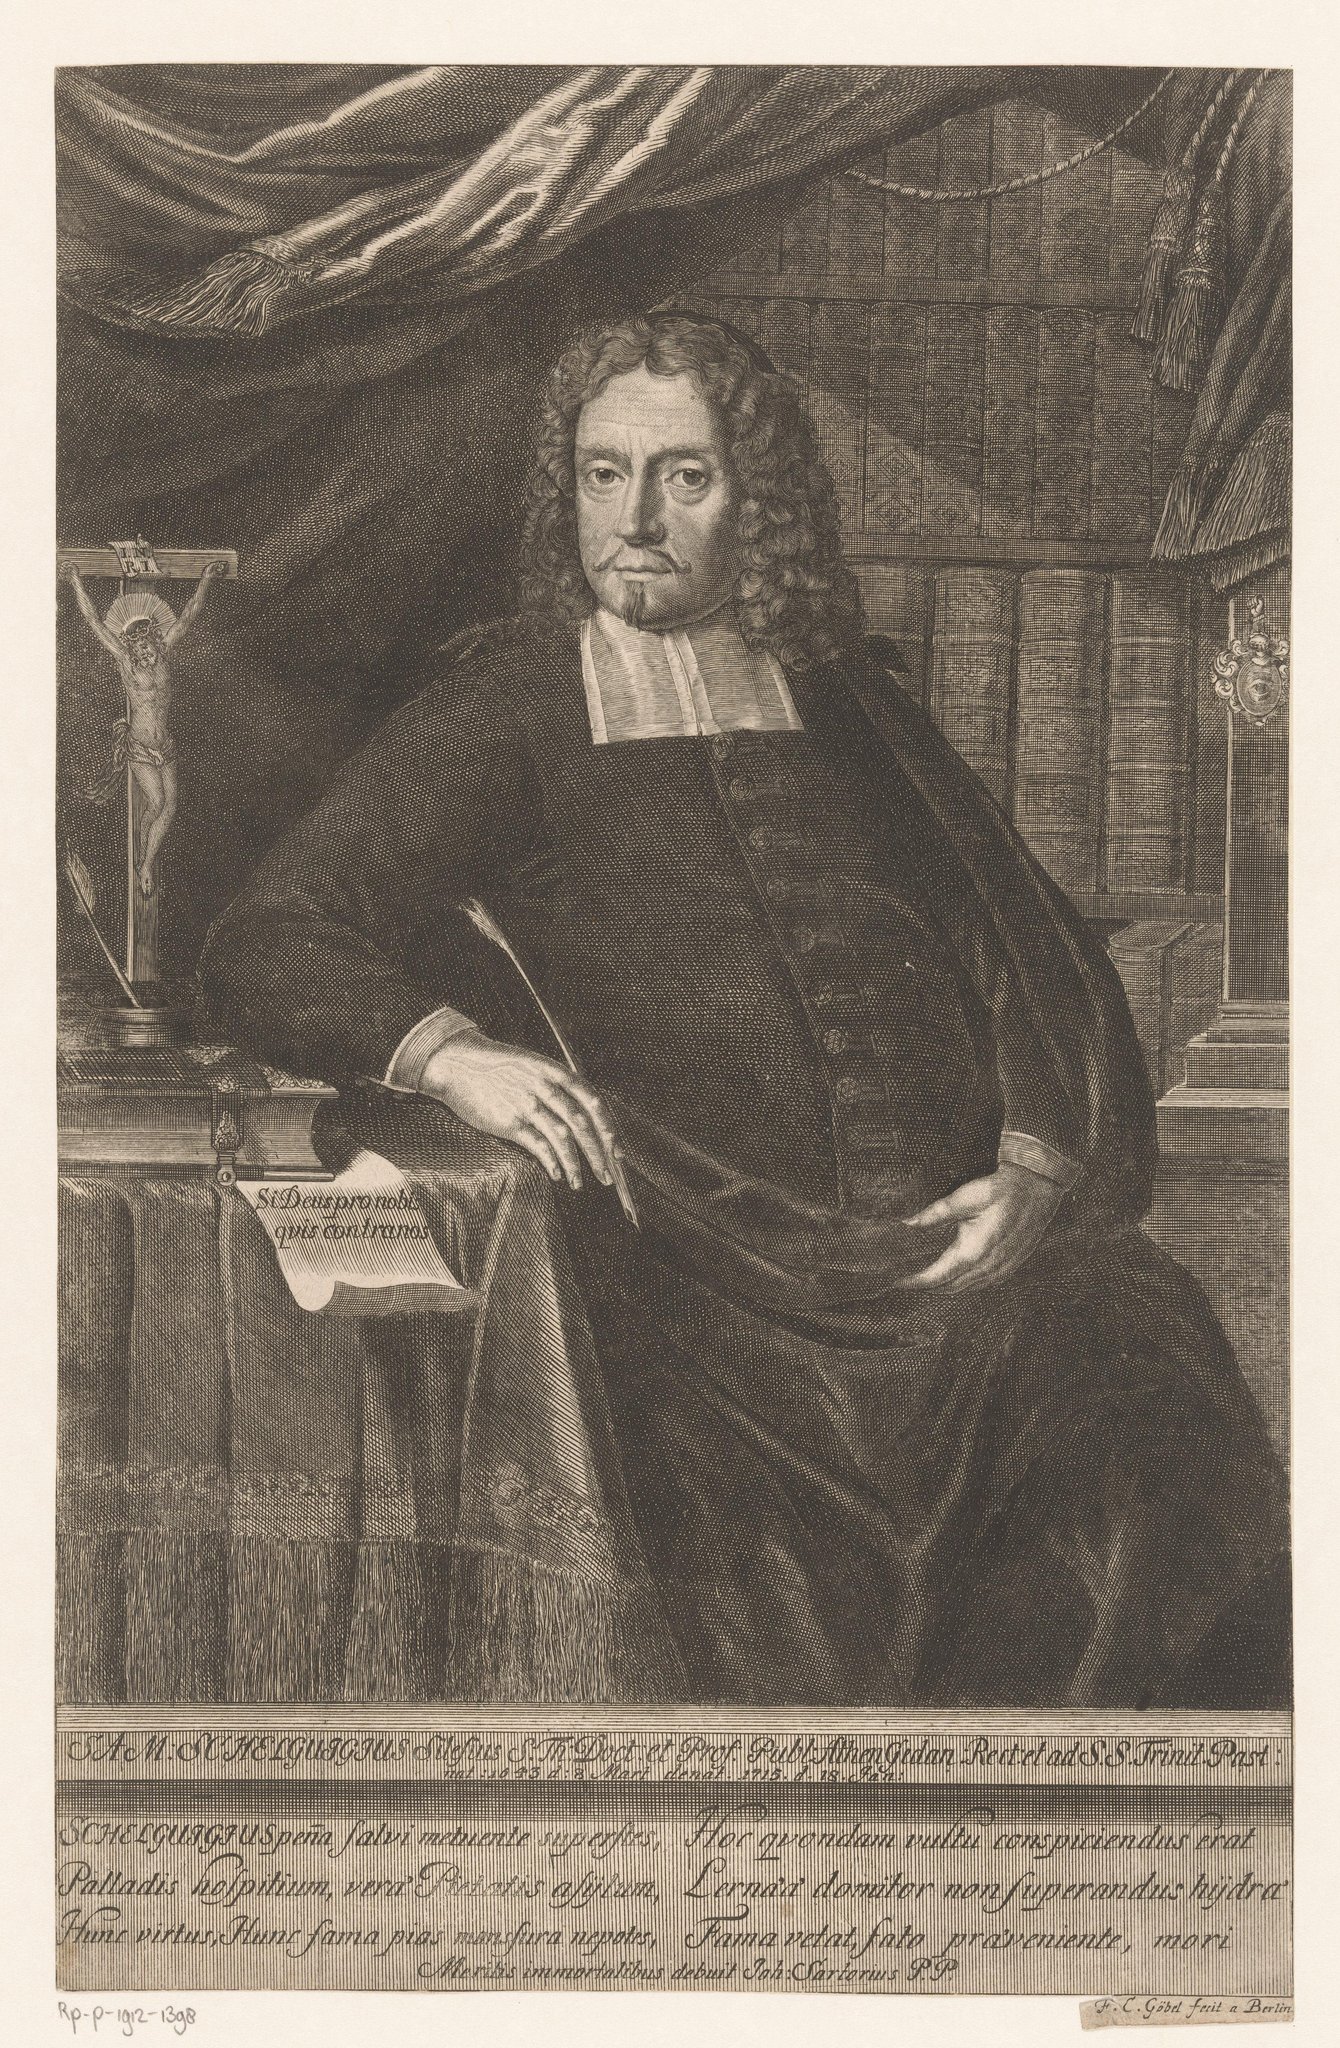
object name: print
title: Portret van Samuel Schelwig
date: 1653-1715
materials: paper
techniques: engraving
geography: berlin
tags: bookshelves, theologian, writing tools, historical persons, crucifix ~ personal devotion, armorial bearing, heraldry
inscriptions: collector's mark: Lugt 2228